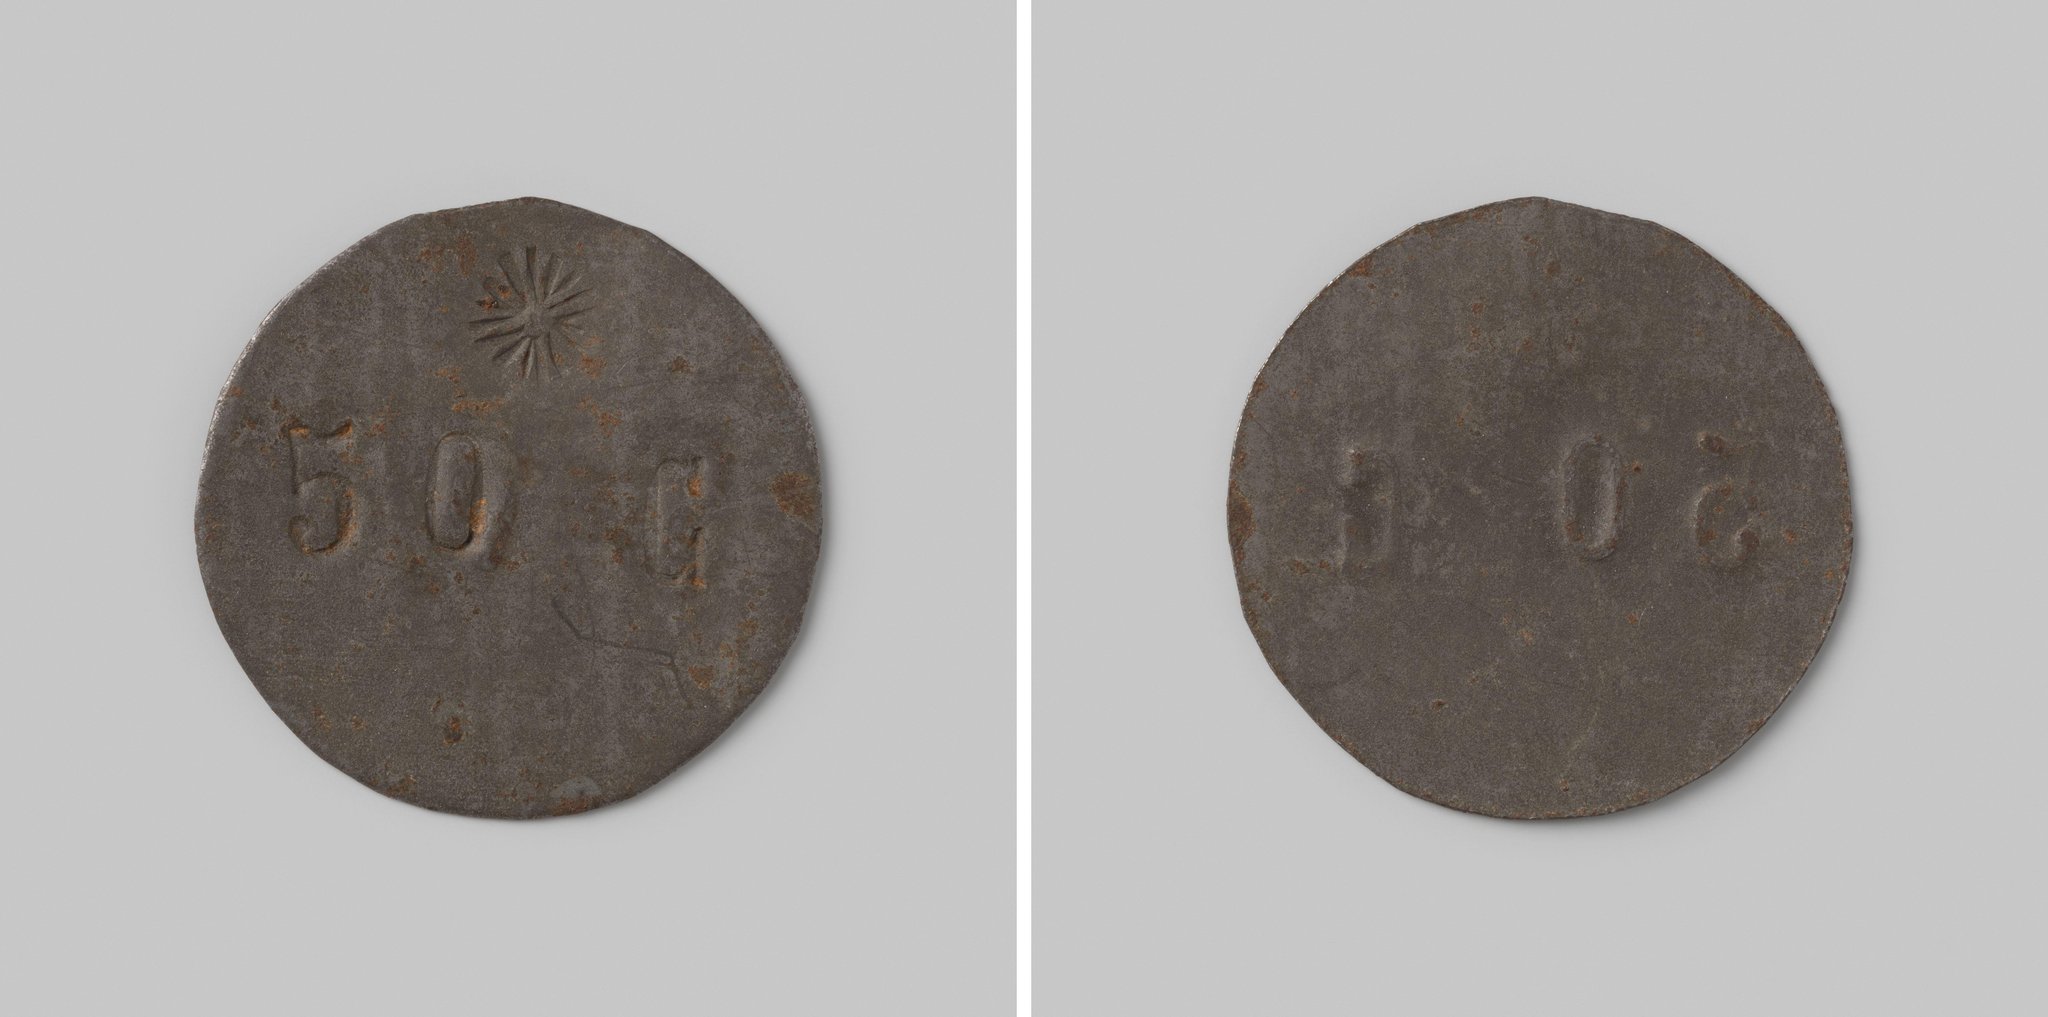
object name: history medal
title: Betaalpenning van 50 cents van de Coöperatieve Winkelvereeniging Eendracht Maakt Magt te Hilversum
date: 1875-1900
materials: zinc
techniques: printing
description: Rond zinken plaatje met inwaartse instempelingen (ster) / 50 C